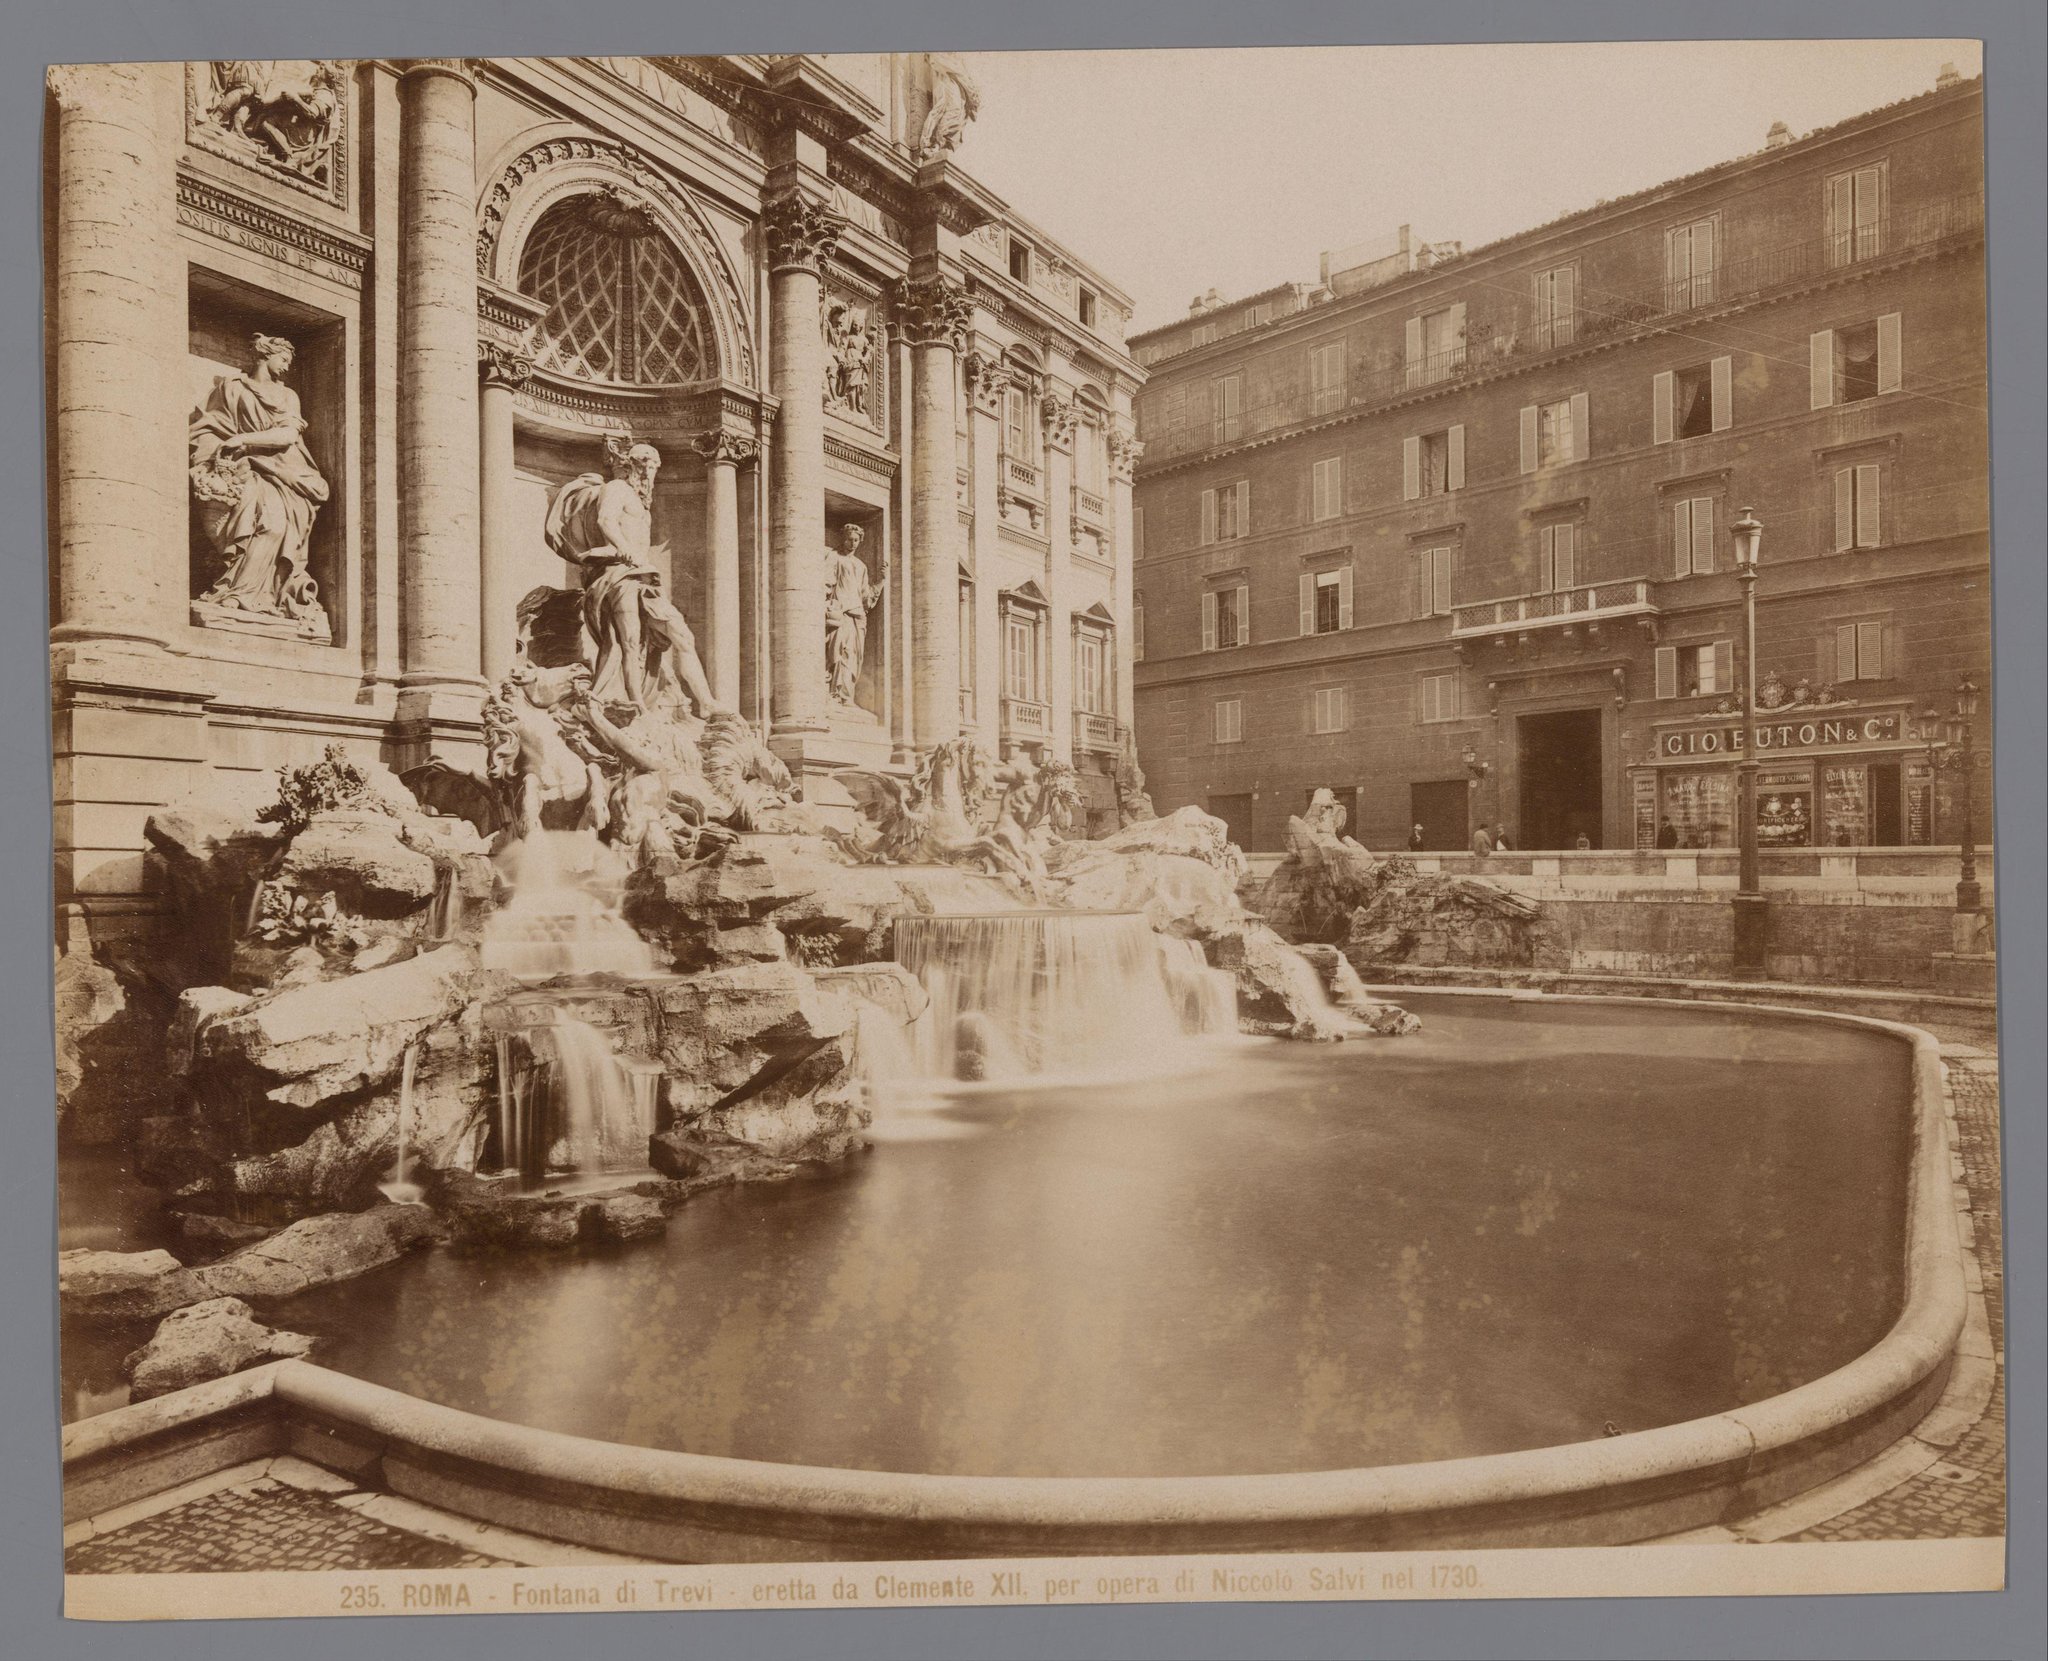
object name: photograph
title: Trevifontein te Rome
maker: Anonymous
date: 1851-1900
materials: cardboard, paper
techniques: albumen print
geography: rome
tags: ornamental fountain, façade (of house or building)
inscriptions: number: ‘235.’